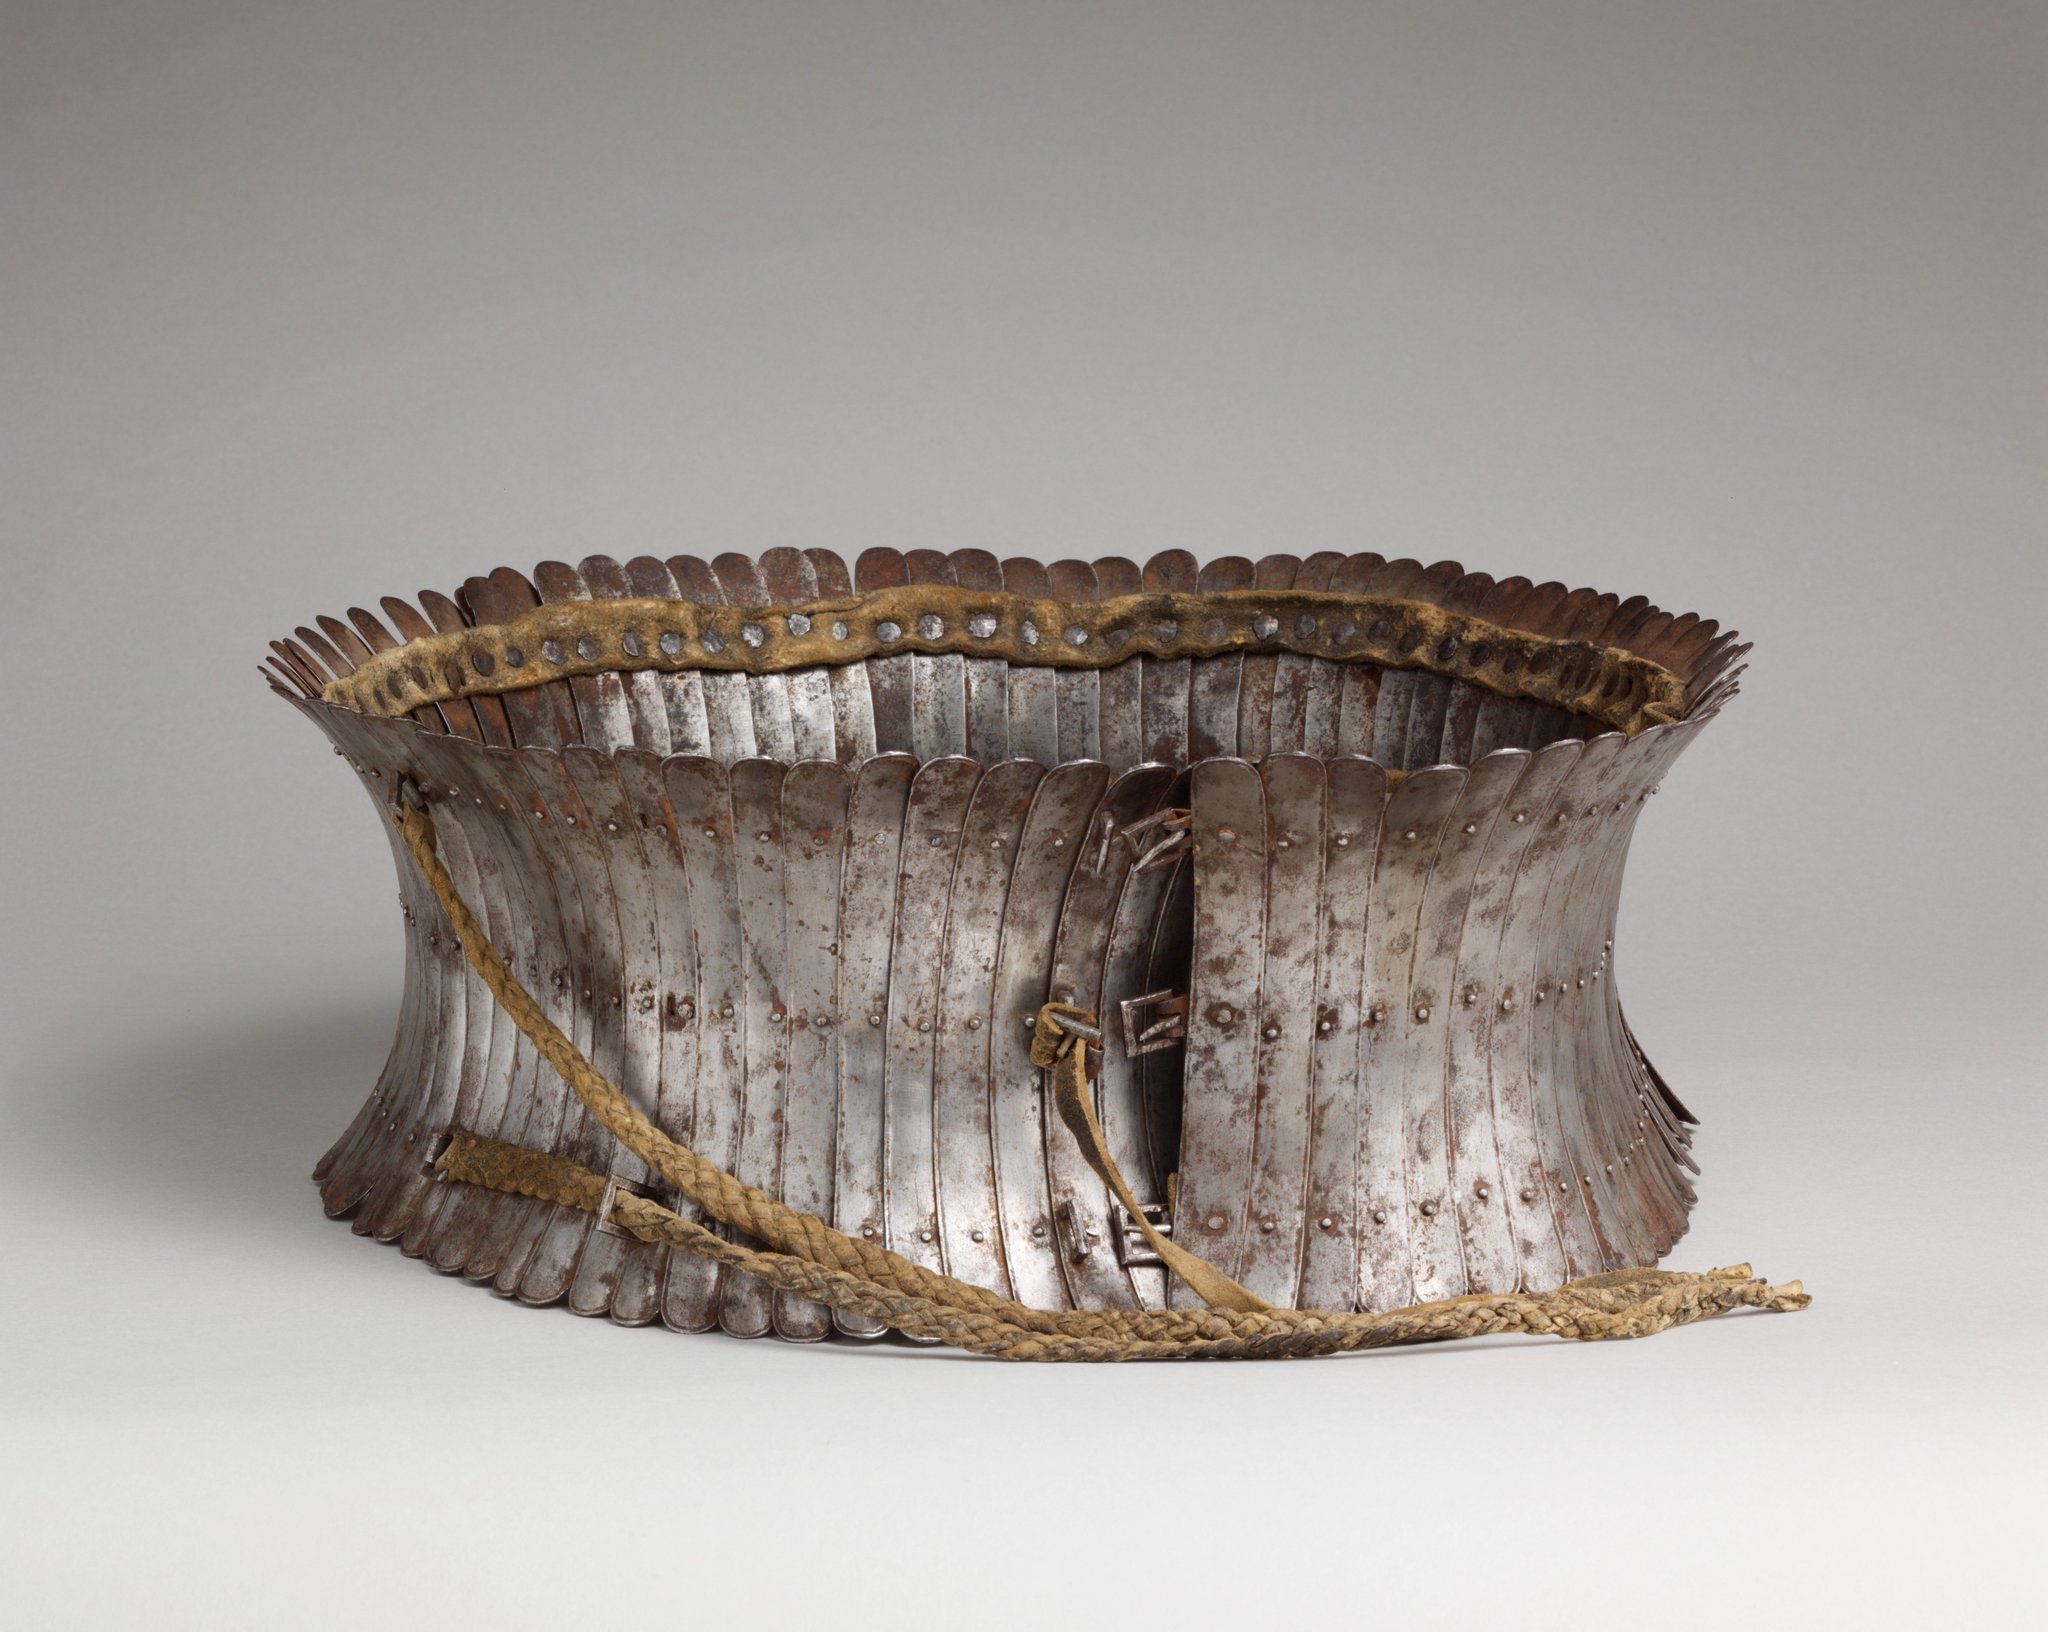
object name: armored belt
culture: tibetan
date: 1601-1900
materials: iron, leather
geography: tibet